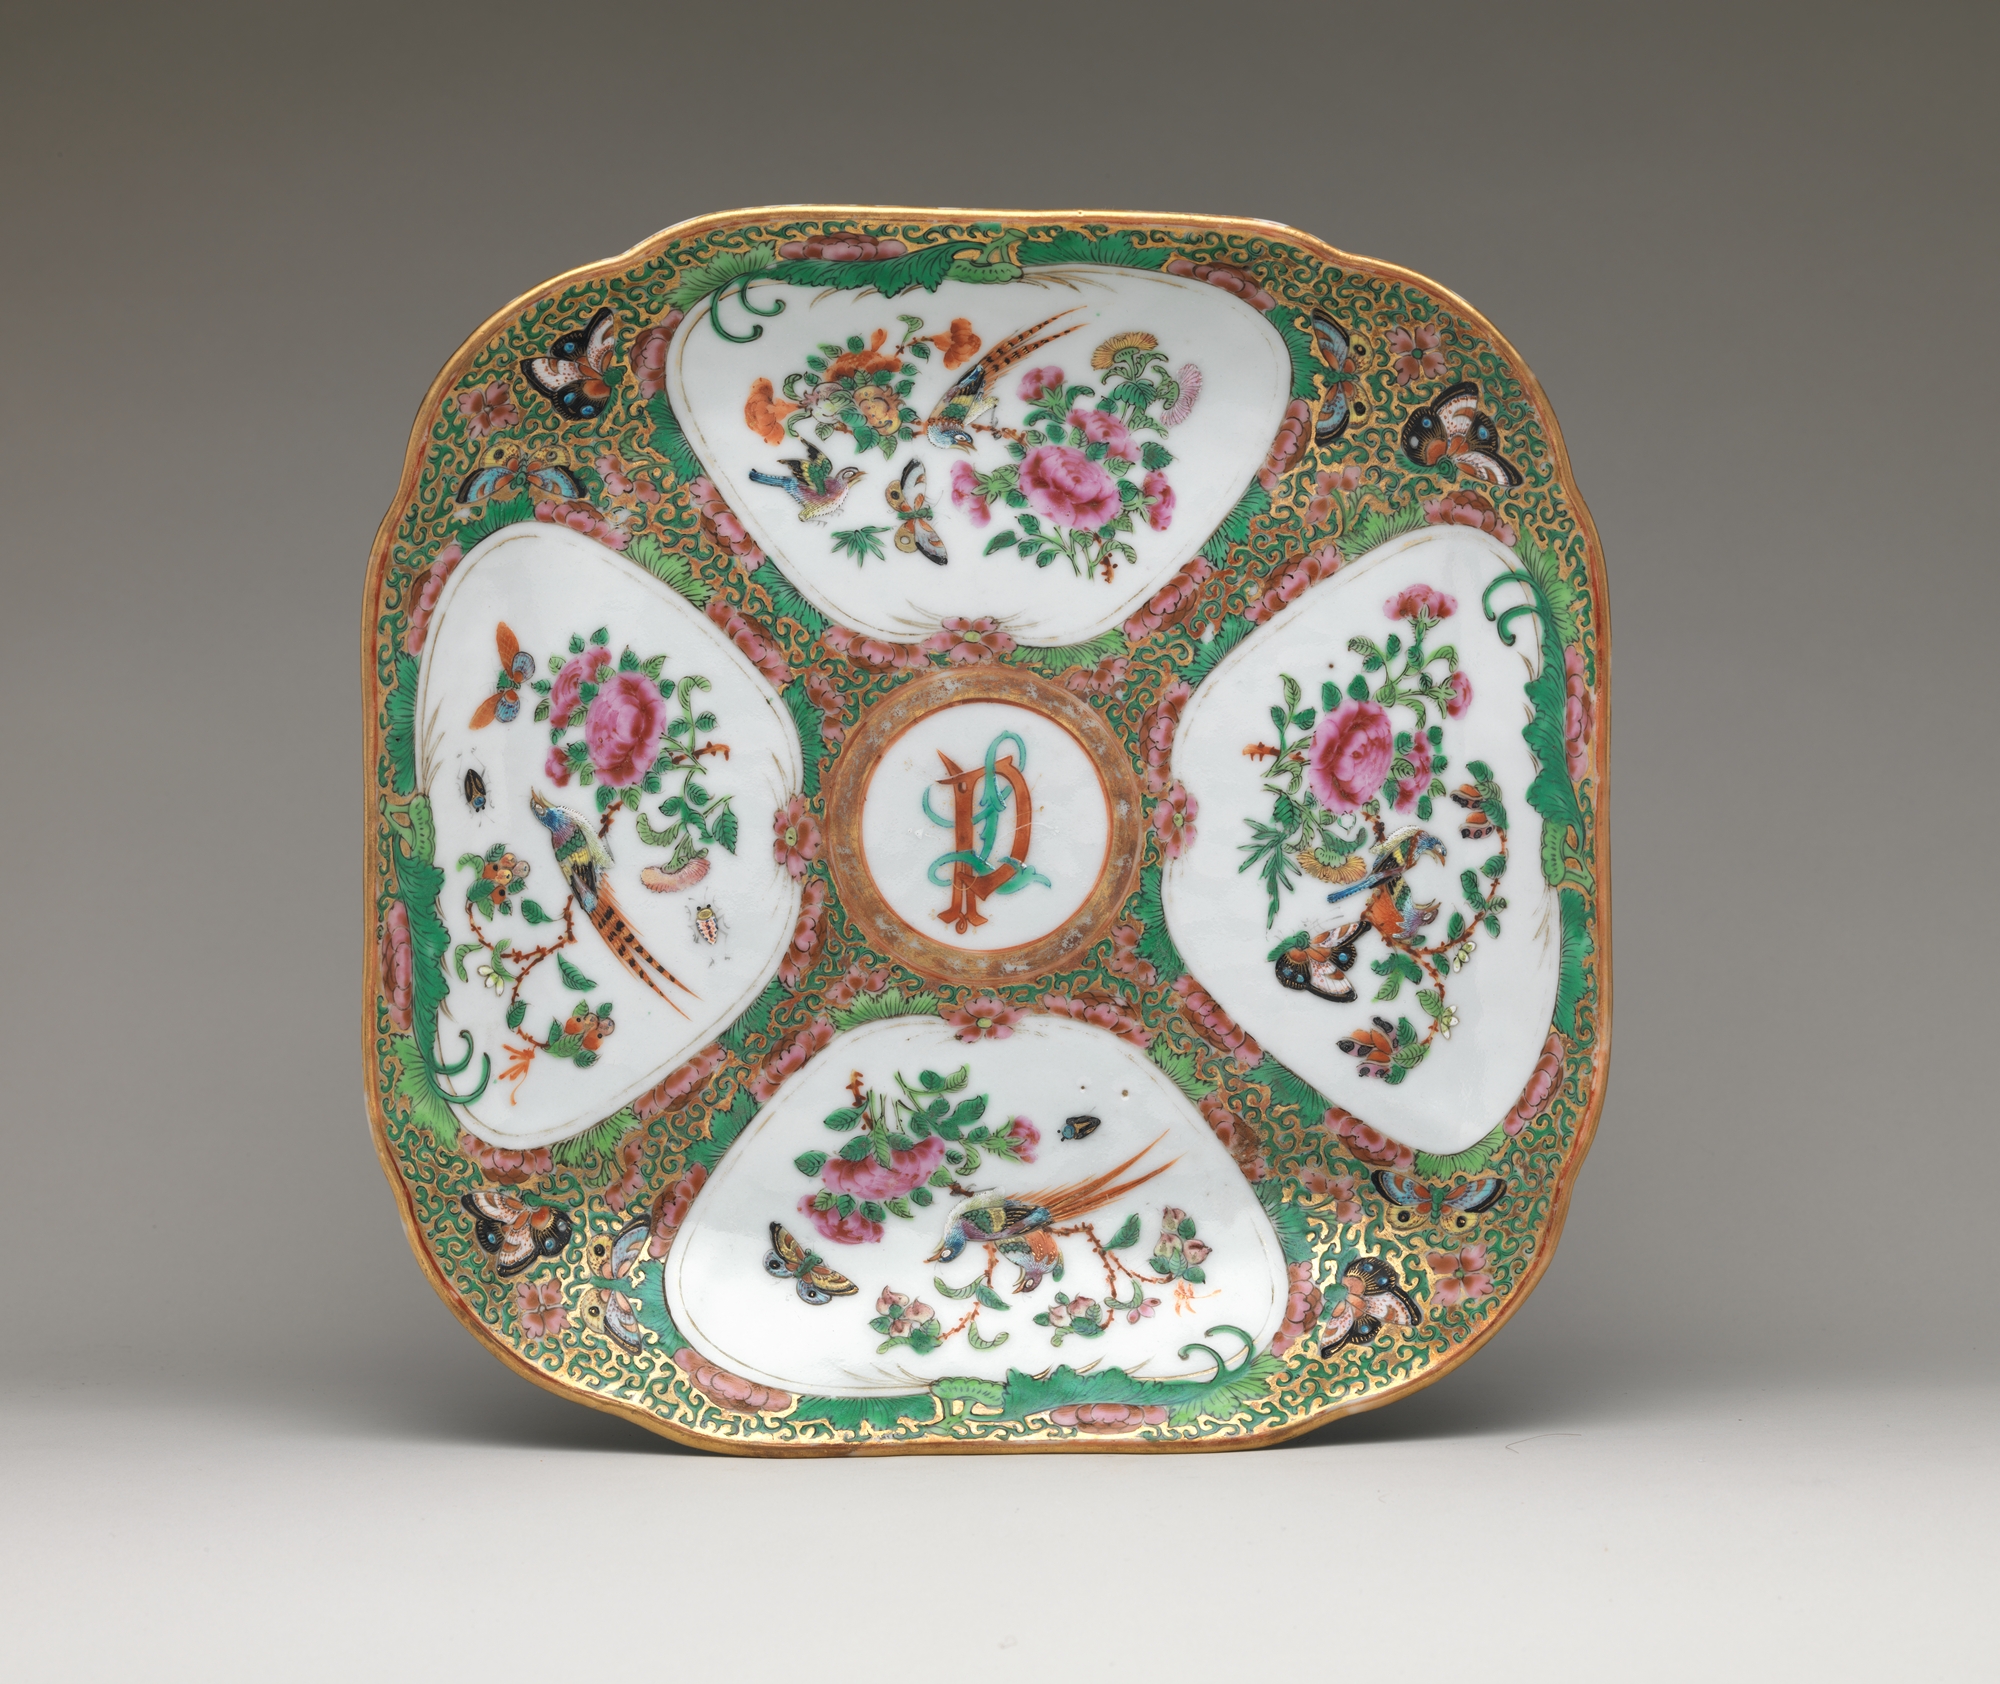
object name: dish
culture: chinese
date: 1860-1866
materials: porcelain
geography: china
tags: birds,flowers